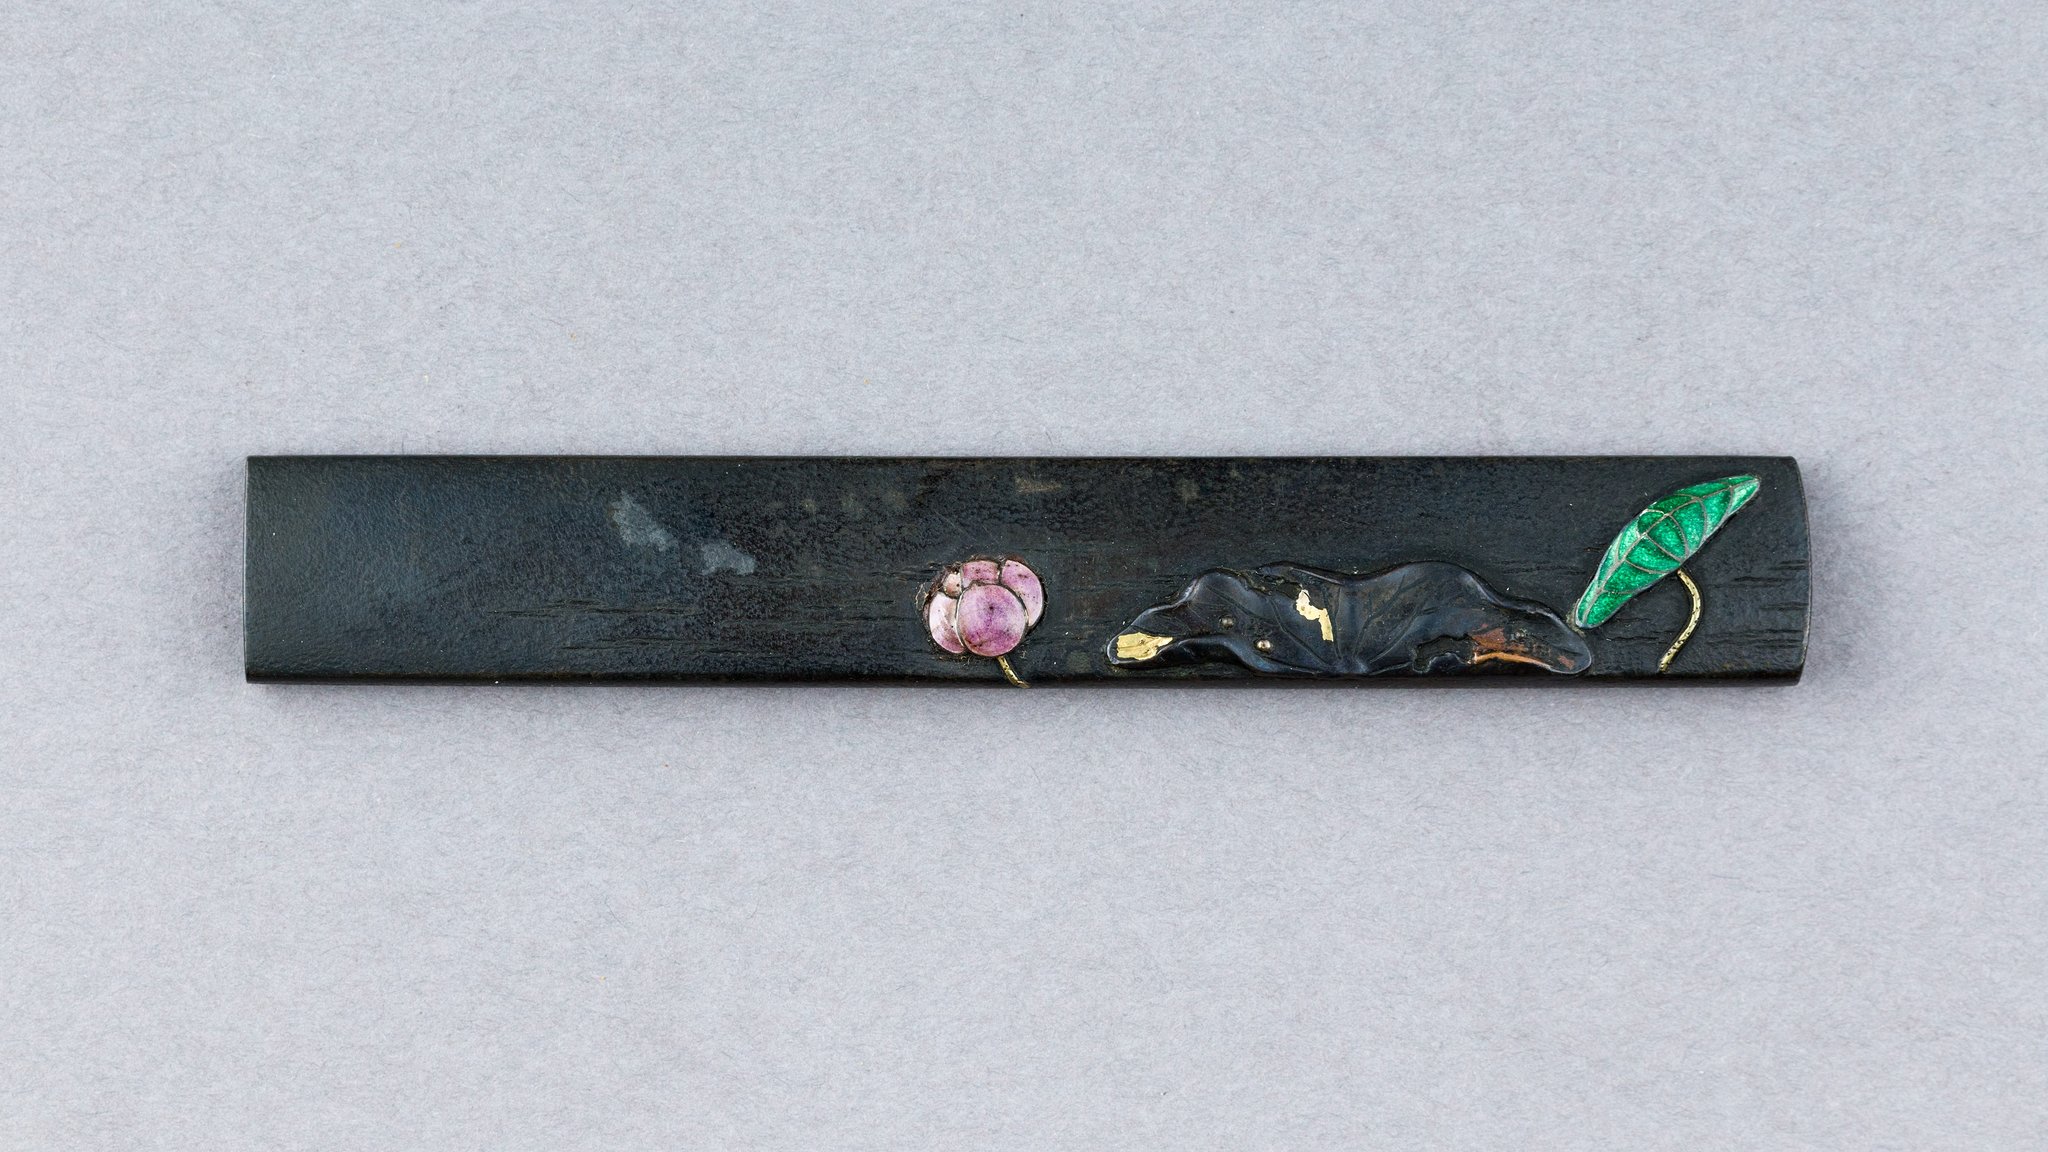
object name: knife handle kozuka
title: Knife Handle (Kozuka)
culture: japanese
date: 1615-1868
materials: copper, gold alloy, silver alloy, enamel, gold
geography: japan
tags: leaves